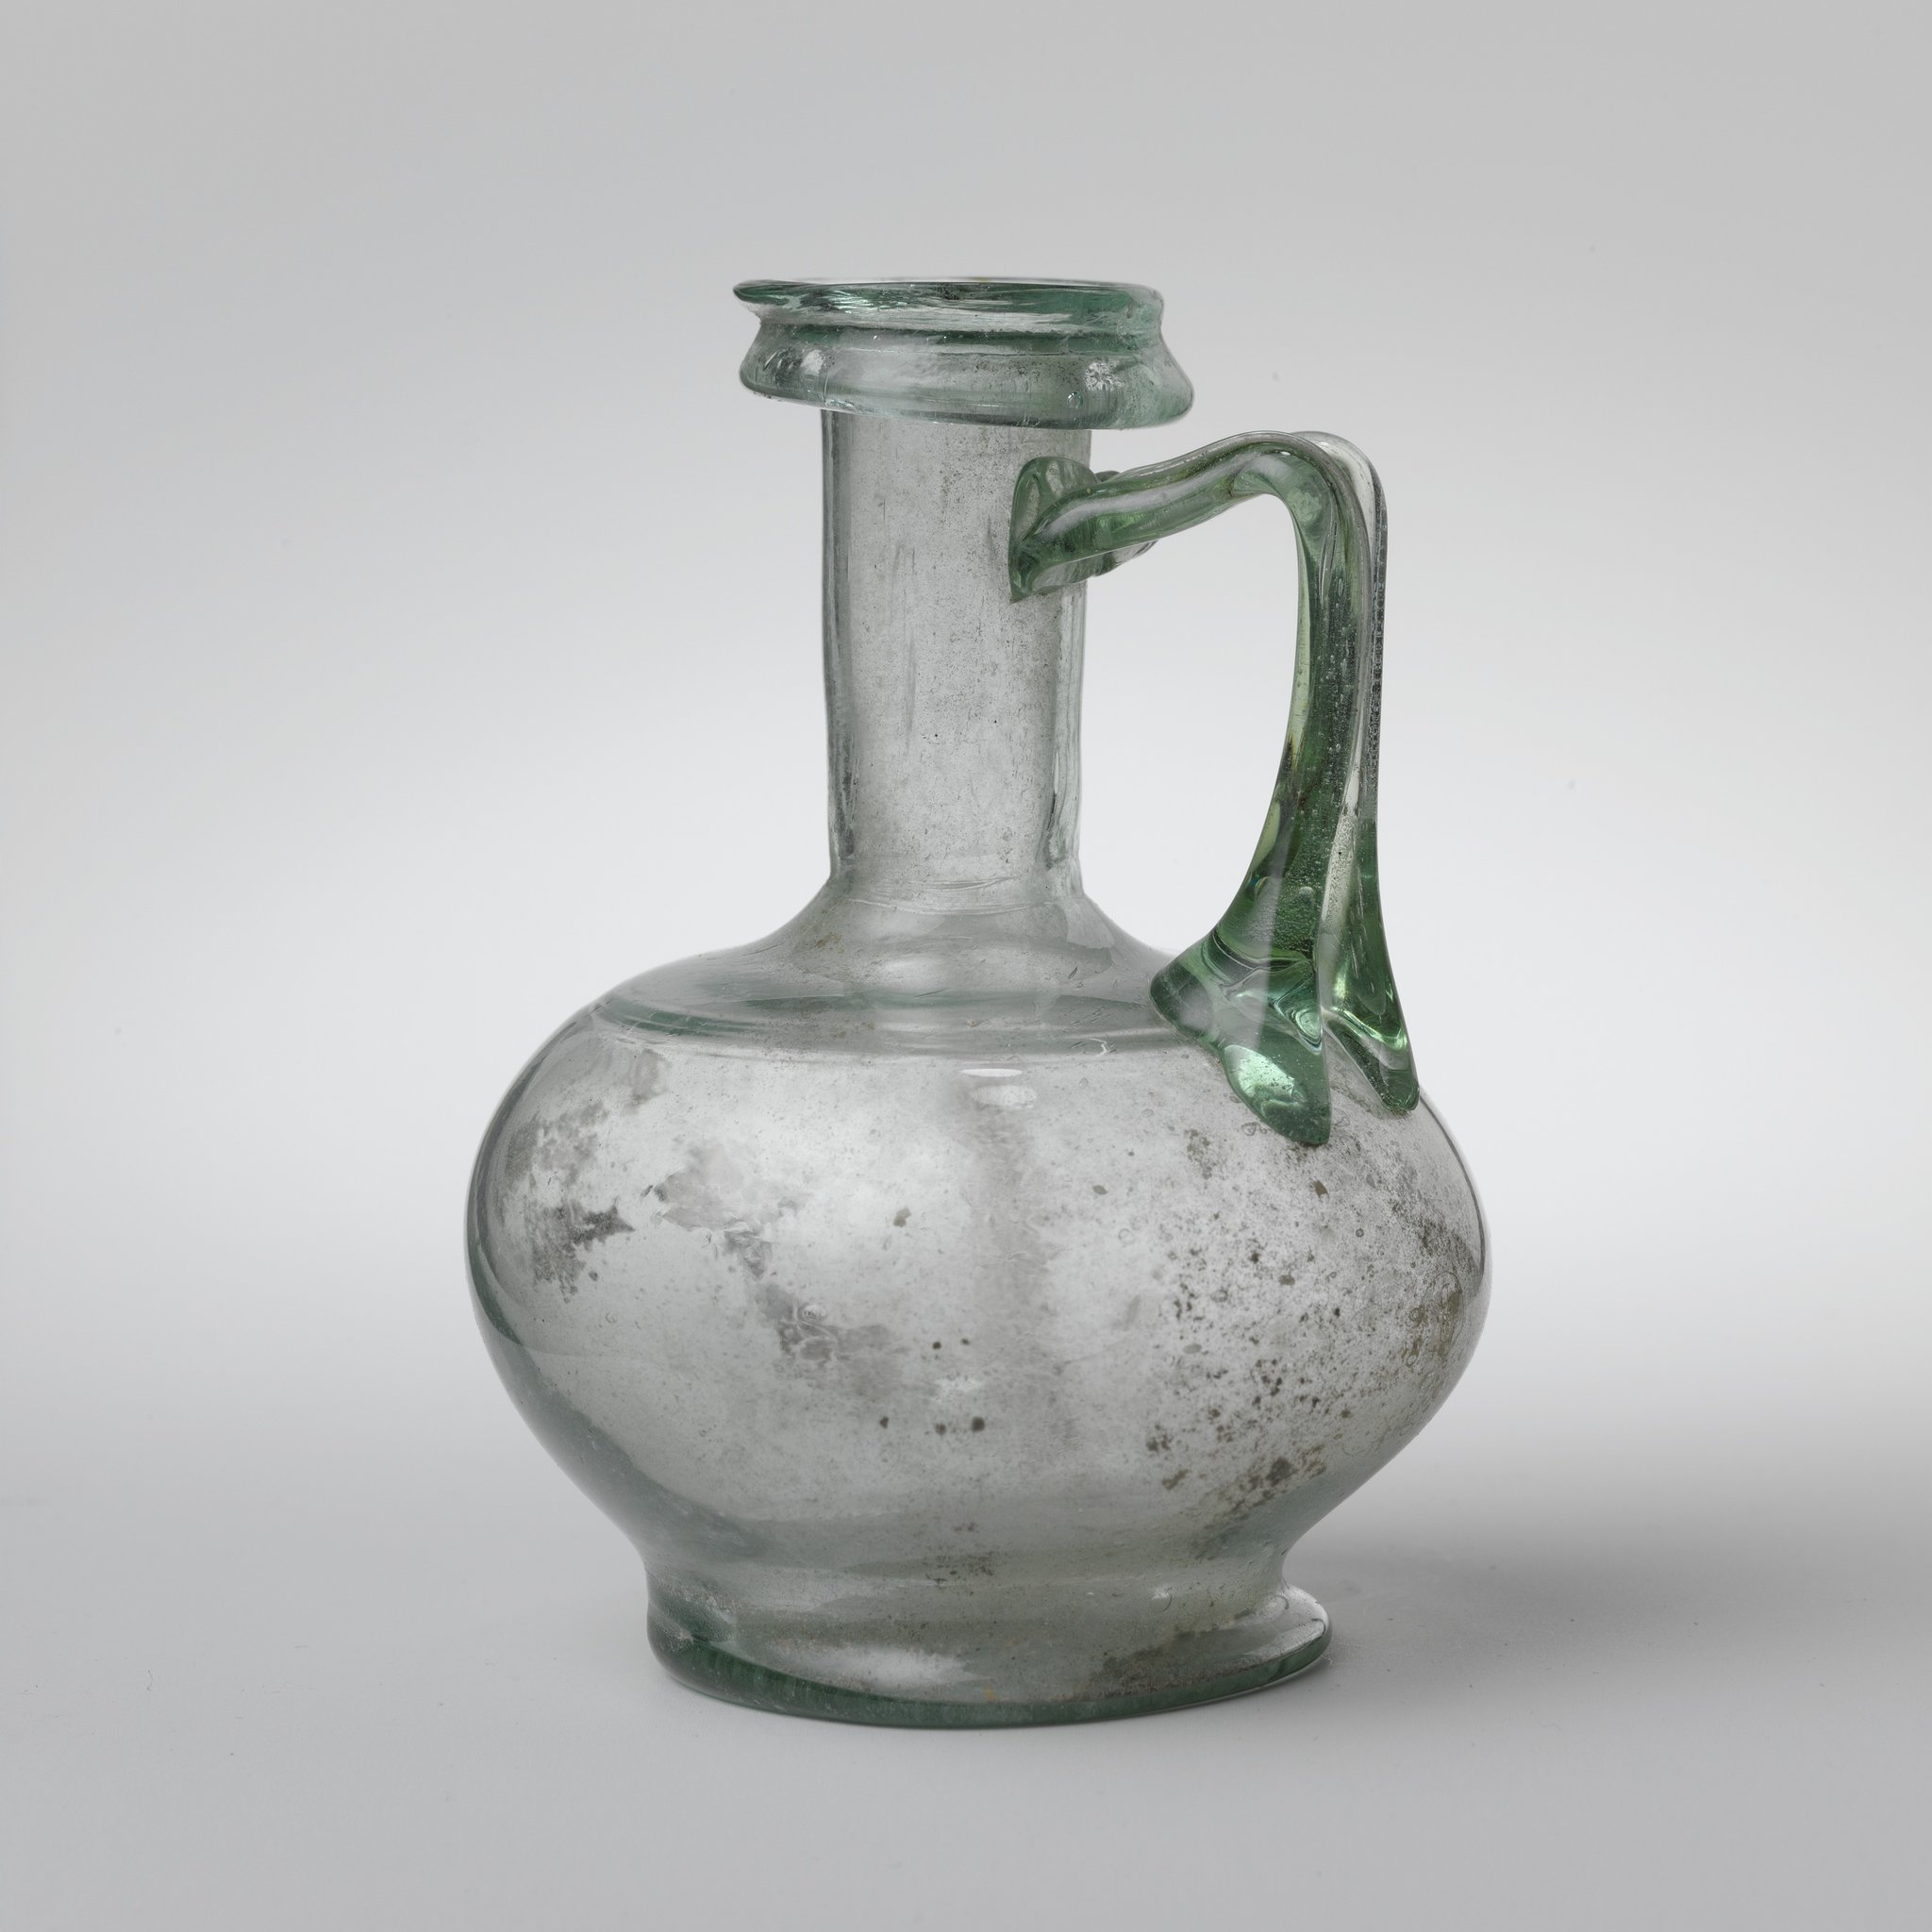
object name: jug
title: Glass jug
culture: roman, cypriot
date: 1-200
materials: glass